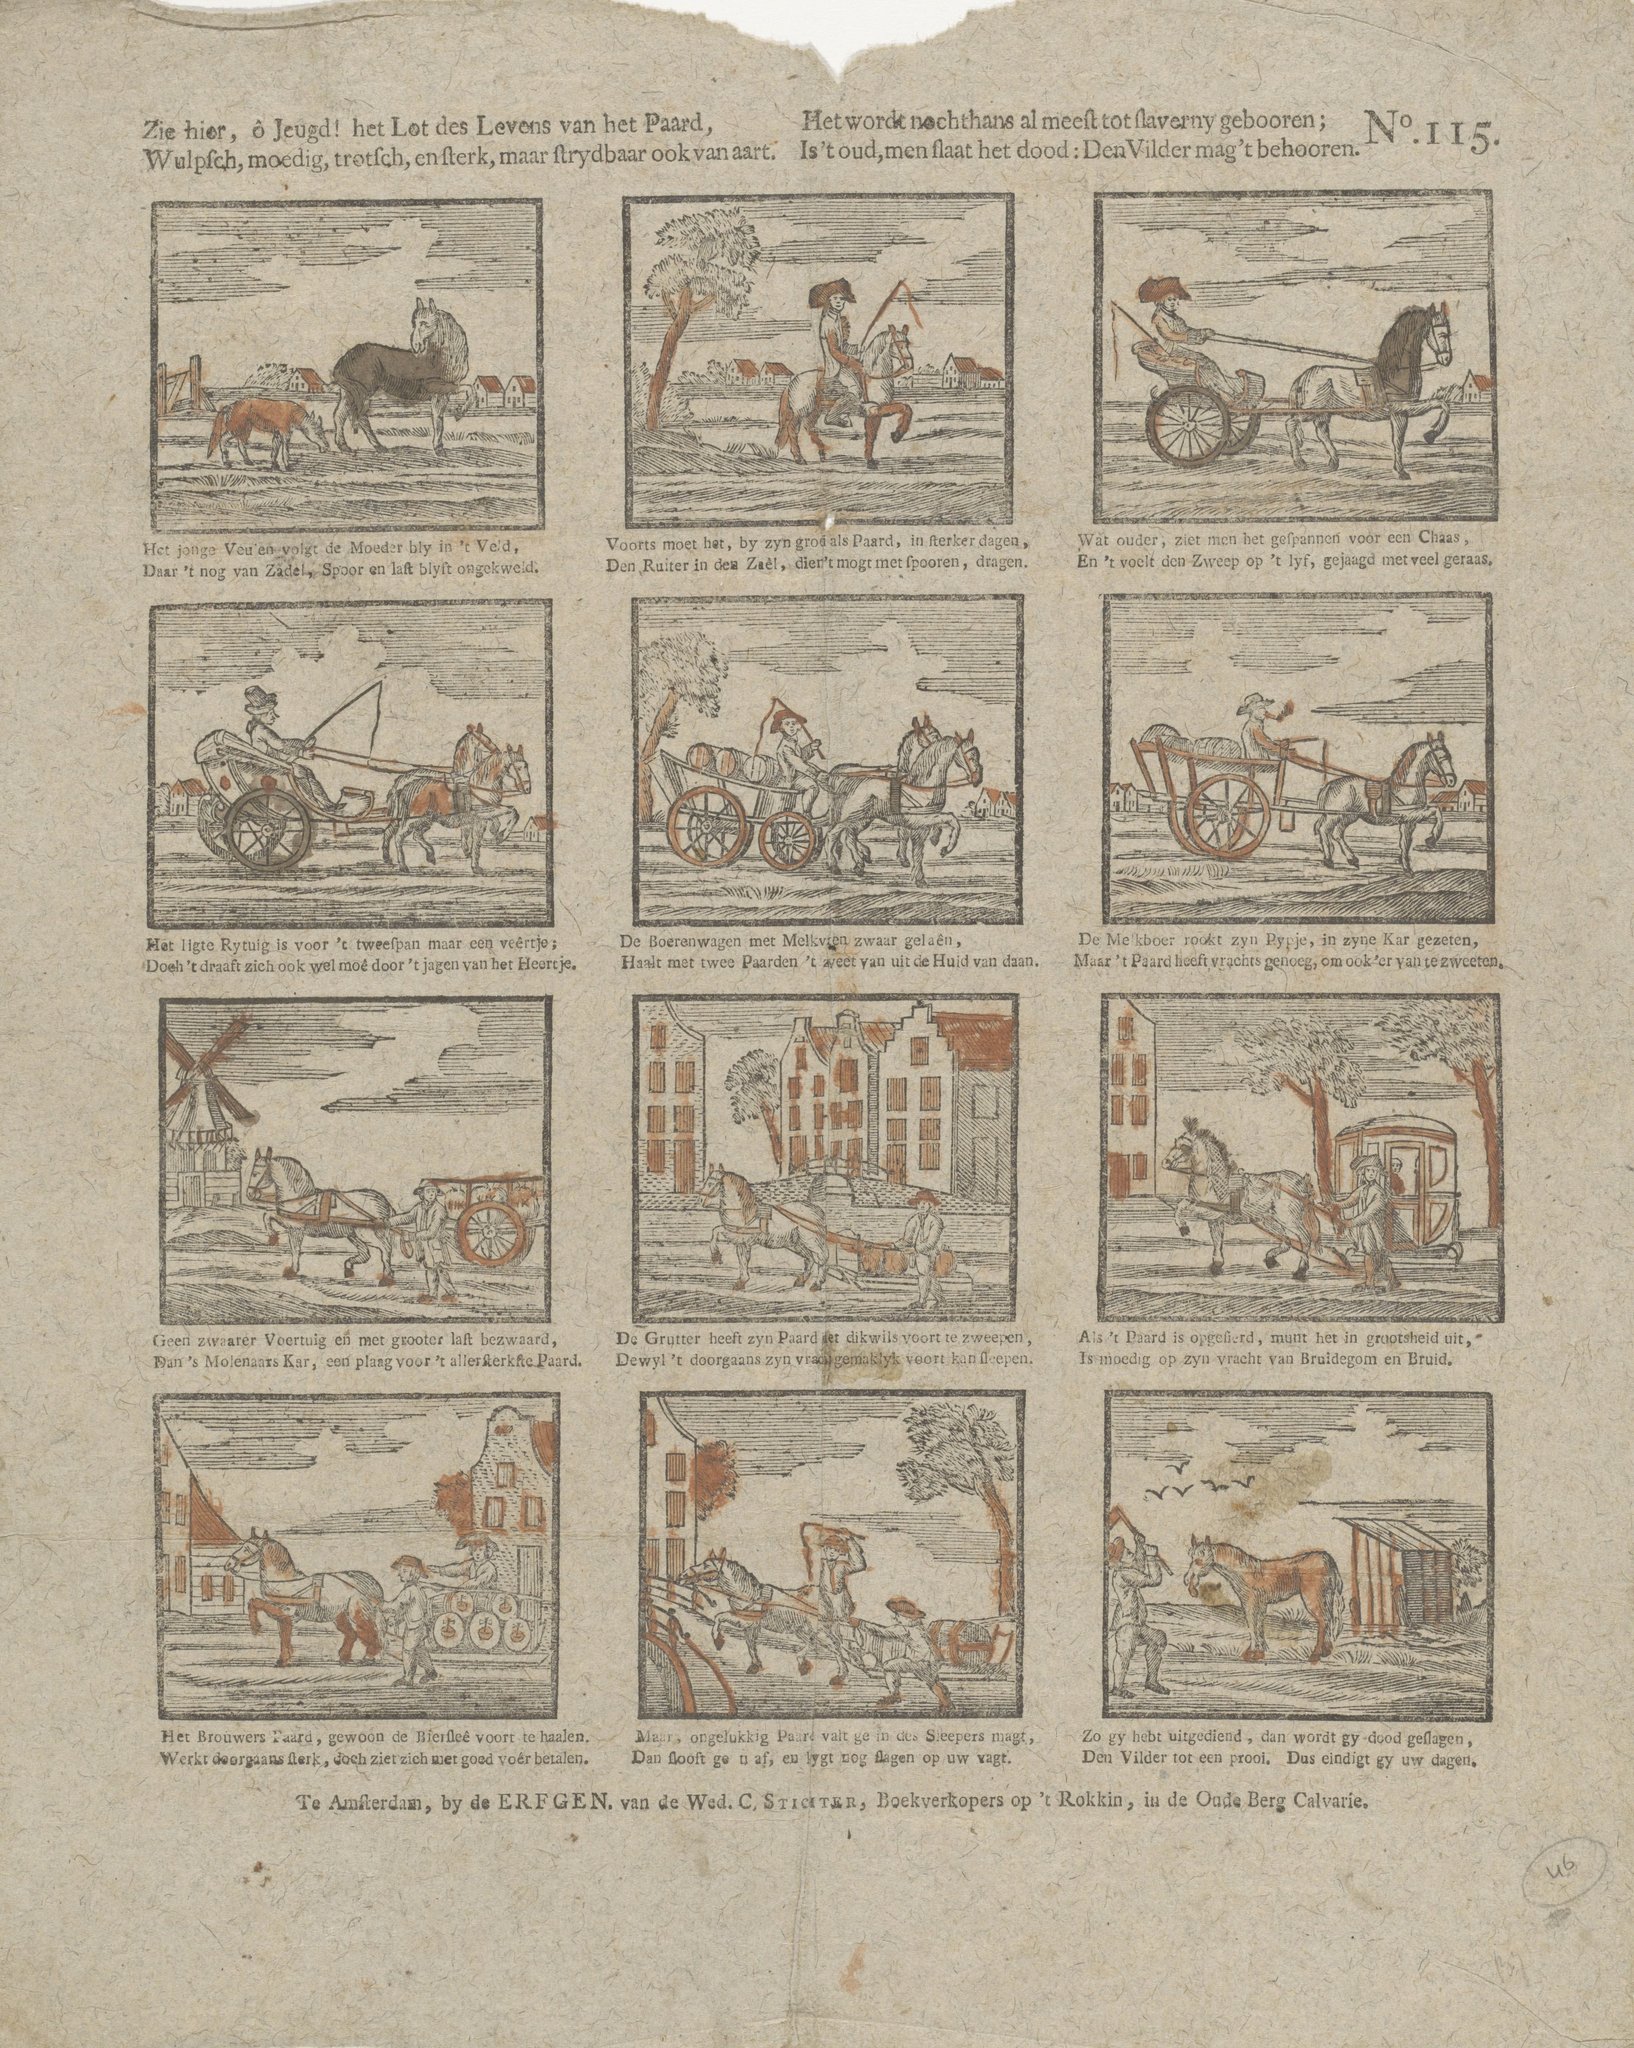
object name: popular print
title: Zie hier, ô Jeugd! het lot des Levens van een Paard, / Wulpsch, moedig, trotsch, en sterk, maar strydbaar ook van aart. / Het wordt nochthans al meest tot slaverny gebooren; / Is 't oud, men slaat het dood: den vilder mag 't behooren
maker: Anonymous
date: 1715-1813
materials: paper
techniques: colour, letterpress printing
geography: netherlands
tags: horse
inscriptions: collector's mark: Lugt 2228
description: Blad met 12 voorstellingen van het leven van een paard. Onder elke afbeelding een tweeregelig vers. Genummerd rechtsboven: No. 115.